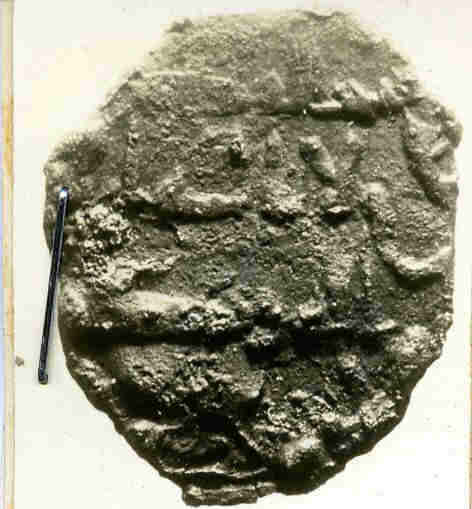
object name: coin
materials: copper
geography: iran